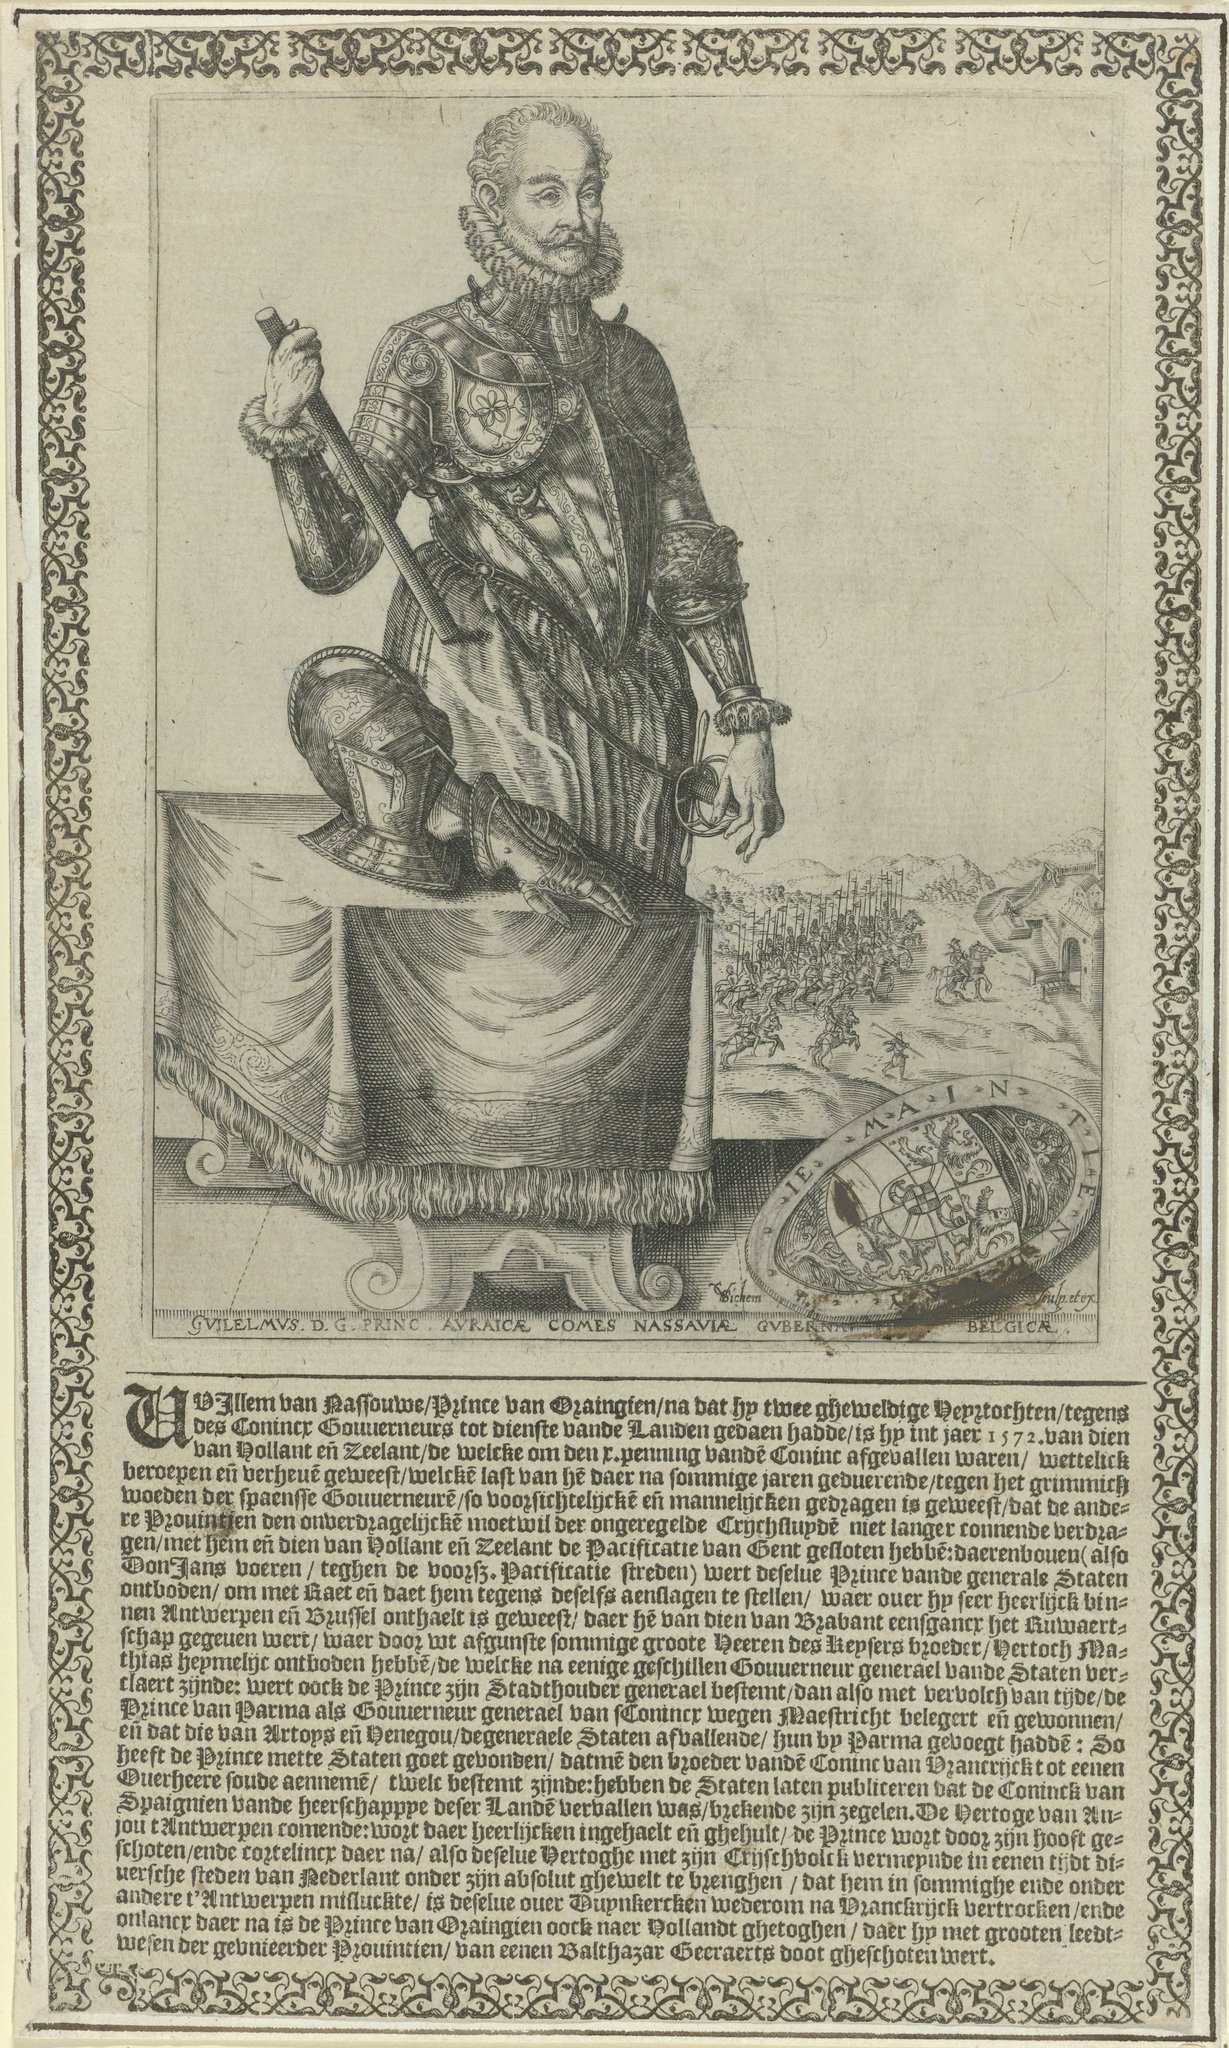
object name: print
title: Portret van Willem I, prins van Oranje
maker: christoffel van sichem (i)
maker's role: print maker, publisher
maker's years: 1546-1624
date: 1600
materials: paper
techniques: engraving, etching, letterpress printing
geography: amsterdam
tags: delft, william i (prince of orange)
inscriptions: collector's mark: Lugt 240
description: Portret van Willem I. Hij staat achter een tafel met een kleed en houdt een commandostaf in de hand. Op de tafel liggen zijn helm en de handschoenen van zijn harnas. Op de grond ligt zijn wapenschild. Op de achtergrond een veldslag. In de ondermarge zijn naam.